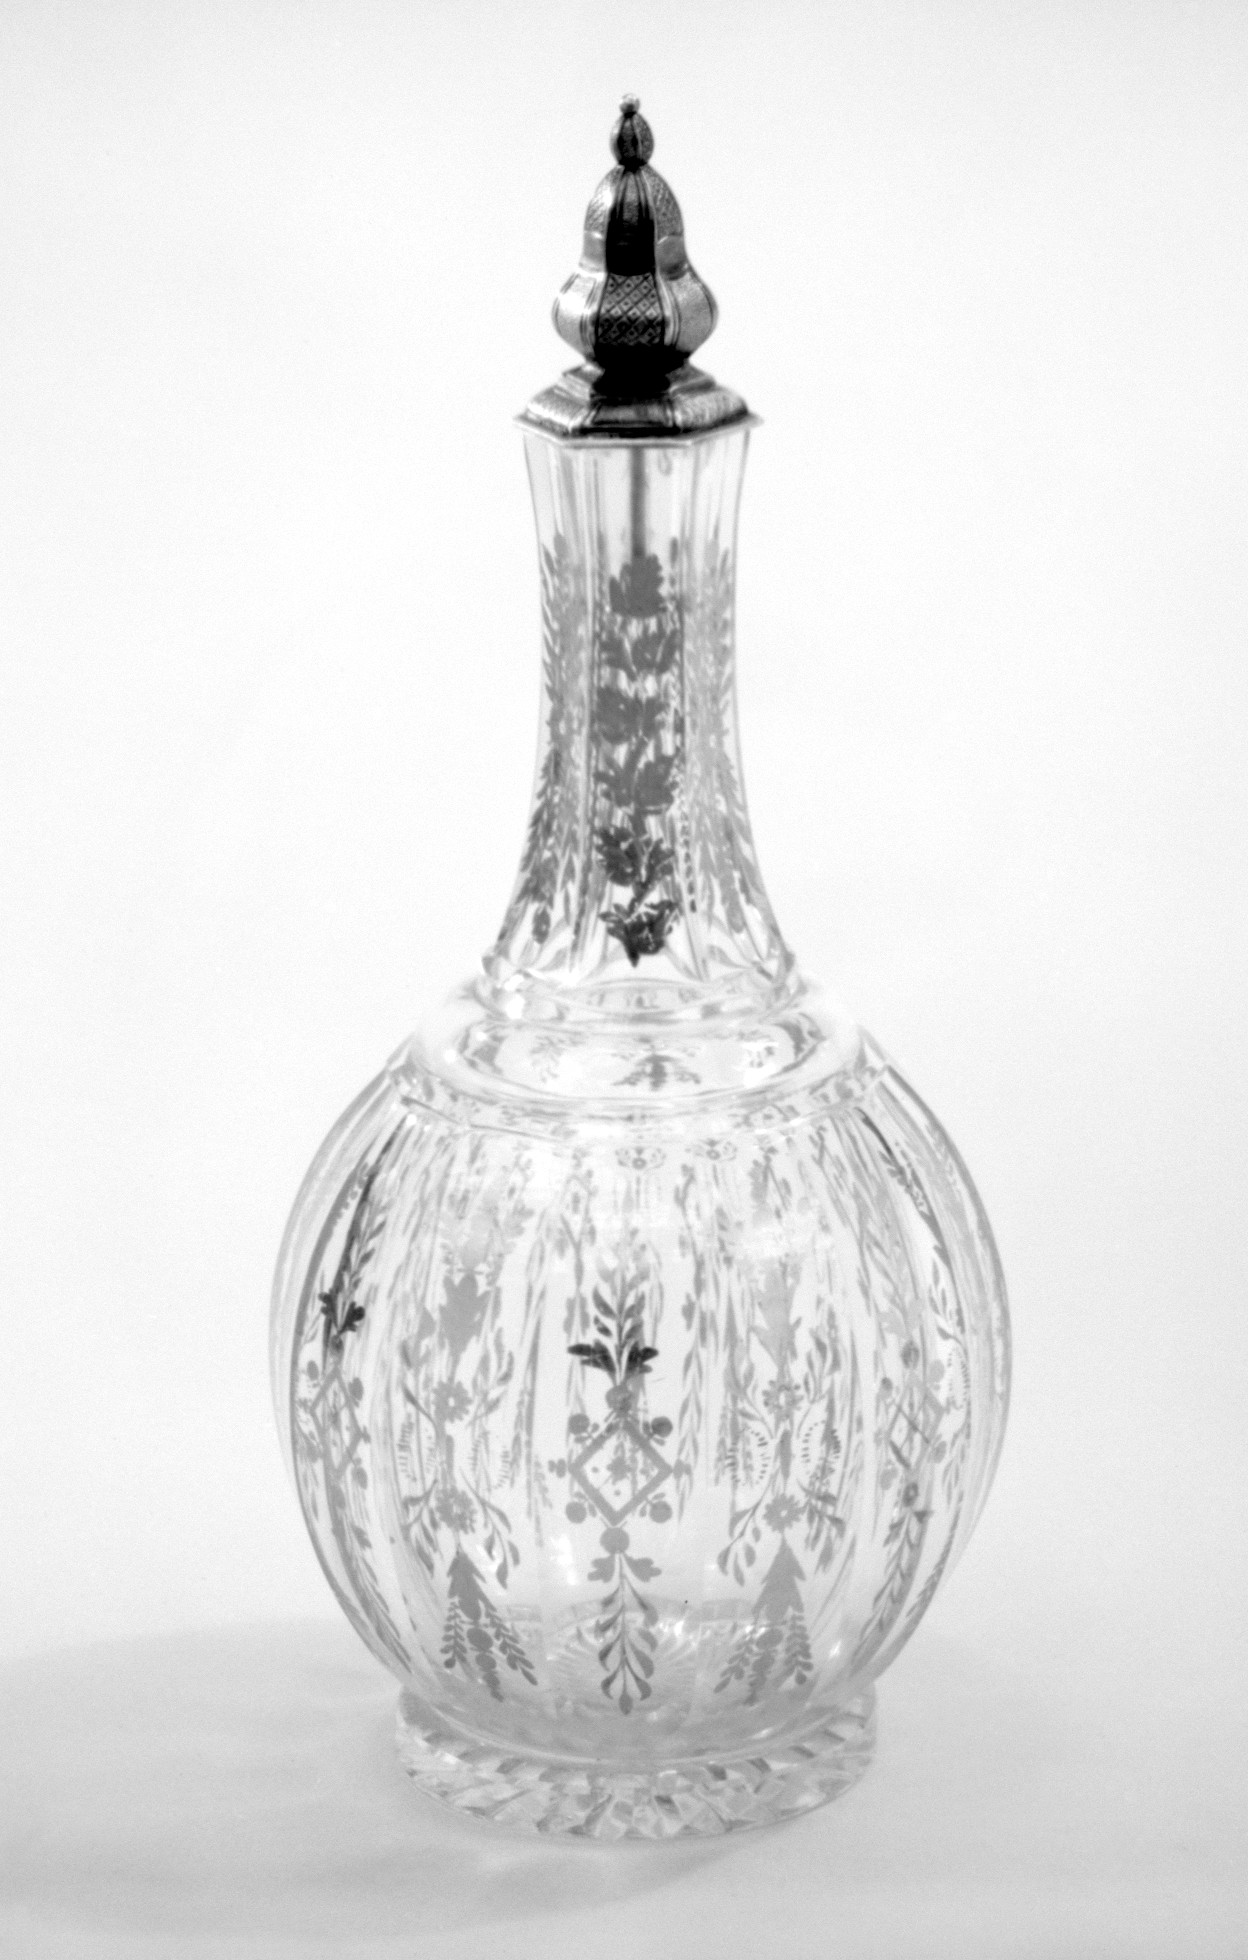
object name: toilet bottle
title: Pair of toilet-water bottles (part of a toilet service)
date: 1801-1900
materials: glass, silver gilt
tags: flowers